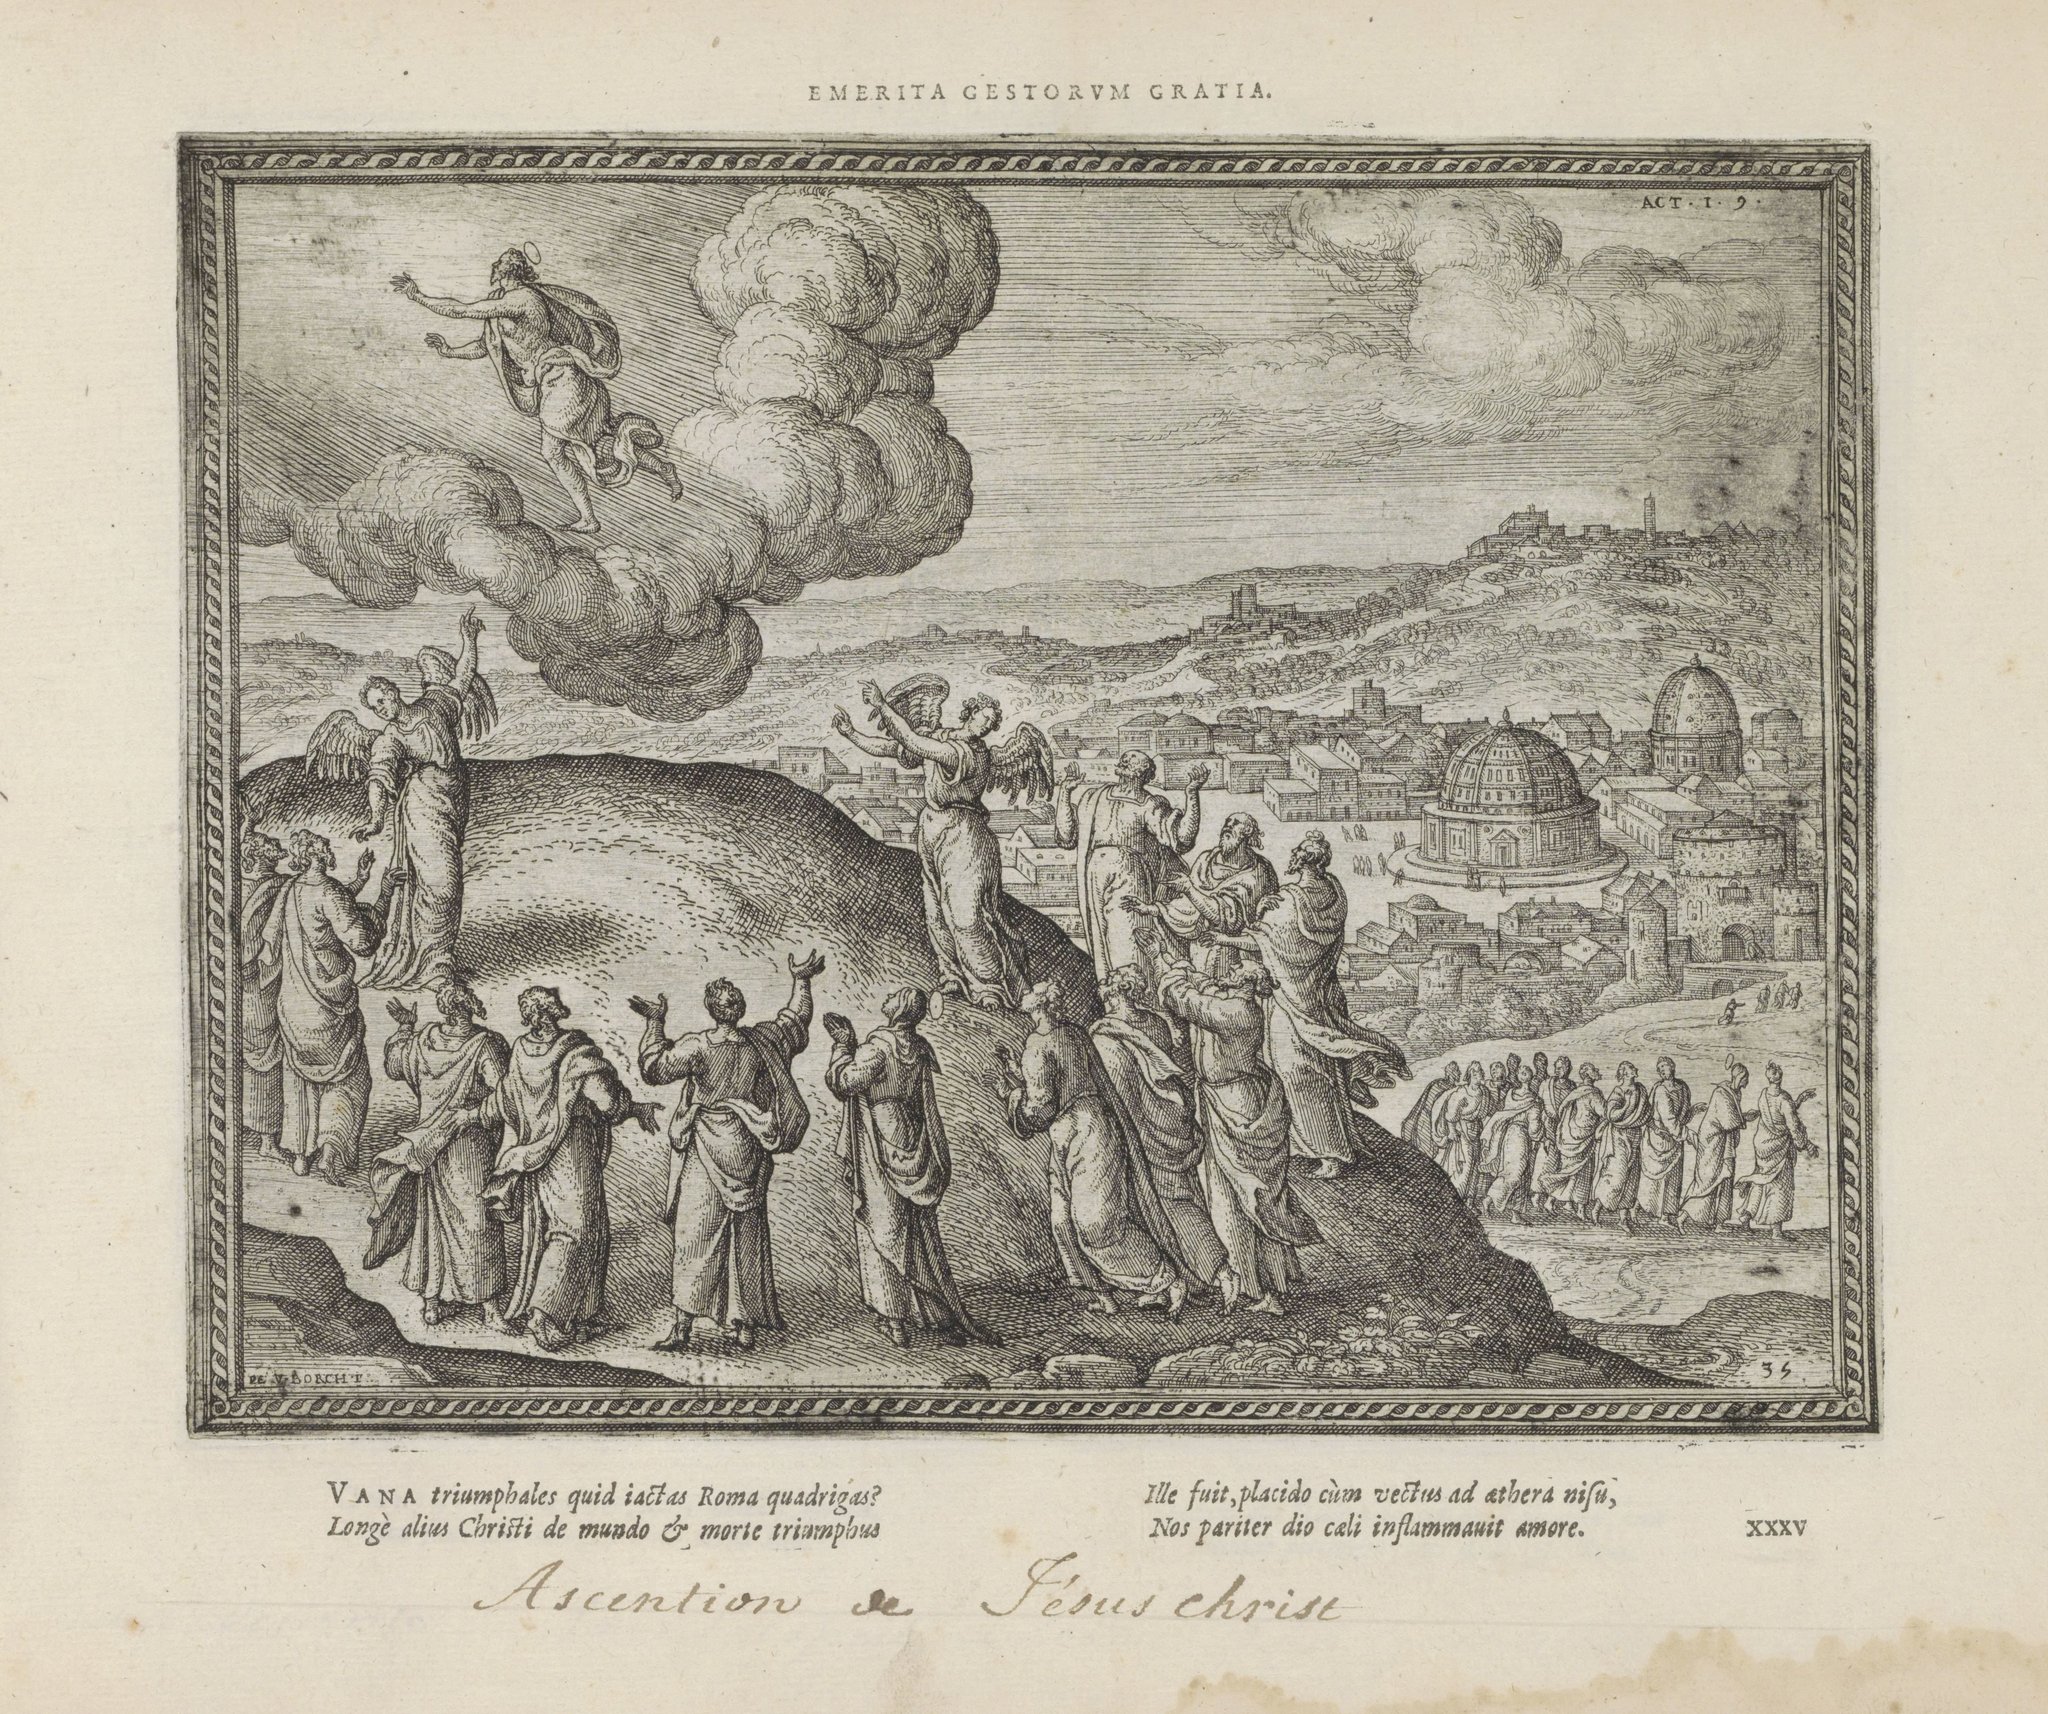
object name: album leaf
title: Hemelvaart van Christus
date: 1582-1593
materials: paper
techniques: etching, letterpress printing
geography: antwerp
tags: angel(s) talking to the apostles and perhaps to other witnesses of the ascension, christ taken up by a cloud ~ ascension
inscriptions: inscription: ‘Ascention de Jésus Christ’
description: Landschap met uitzicht op de stad Jeruzalem. Links de Olijfberg met de Hemelvaart van Christus. Christus wordt op een wolk meegevoerd, terwijl de twaalf apostelen toekijken. Naast de apostelen twee engelen (Handelingen 1). Met een motto in het Latijn boven de voorstelling en een vierregelig onderschrift in het Latijn onder de prent. De prent maakt deel uit van een album.